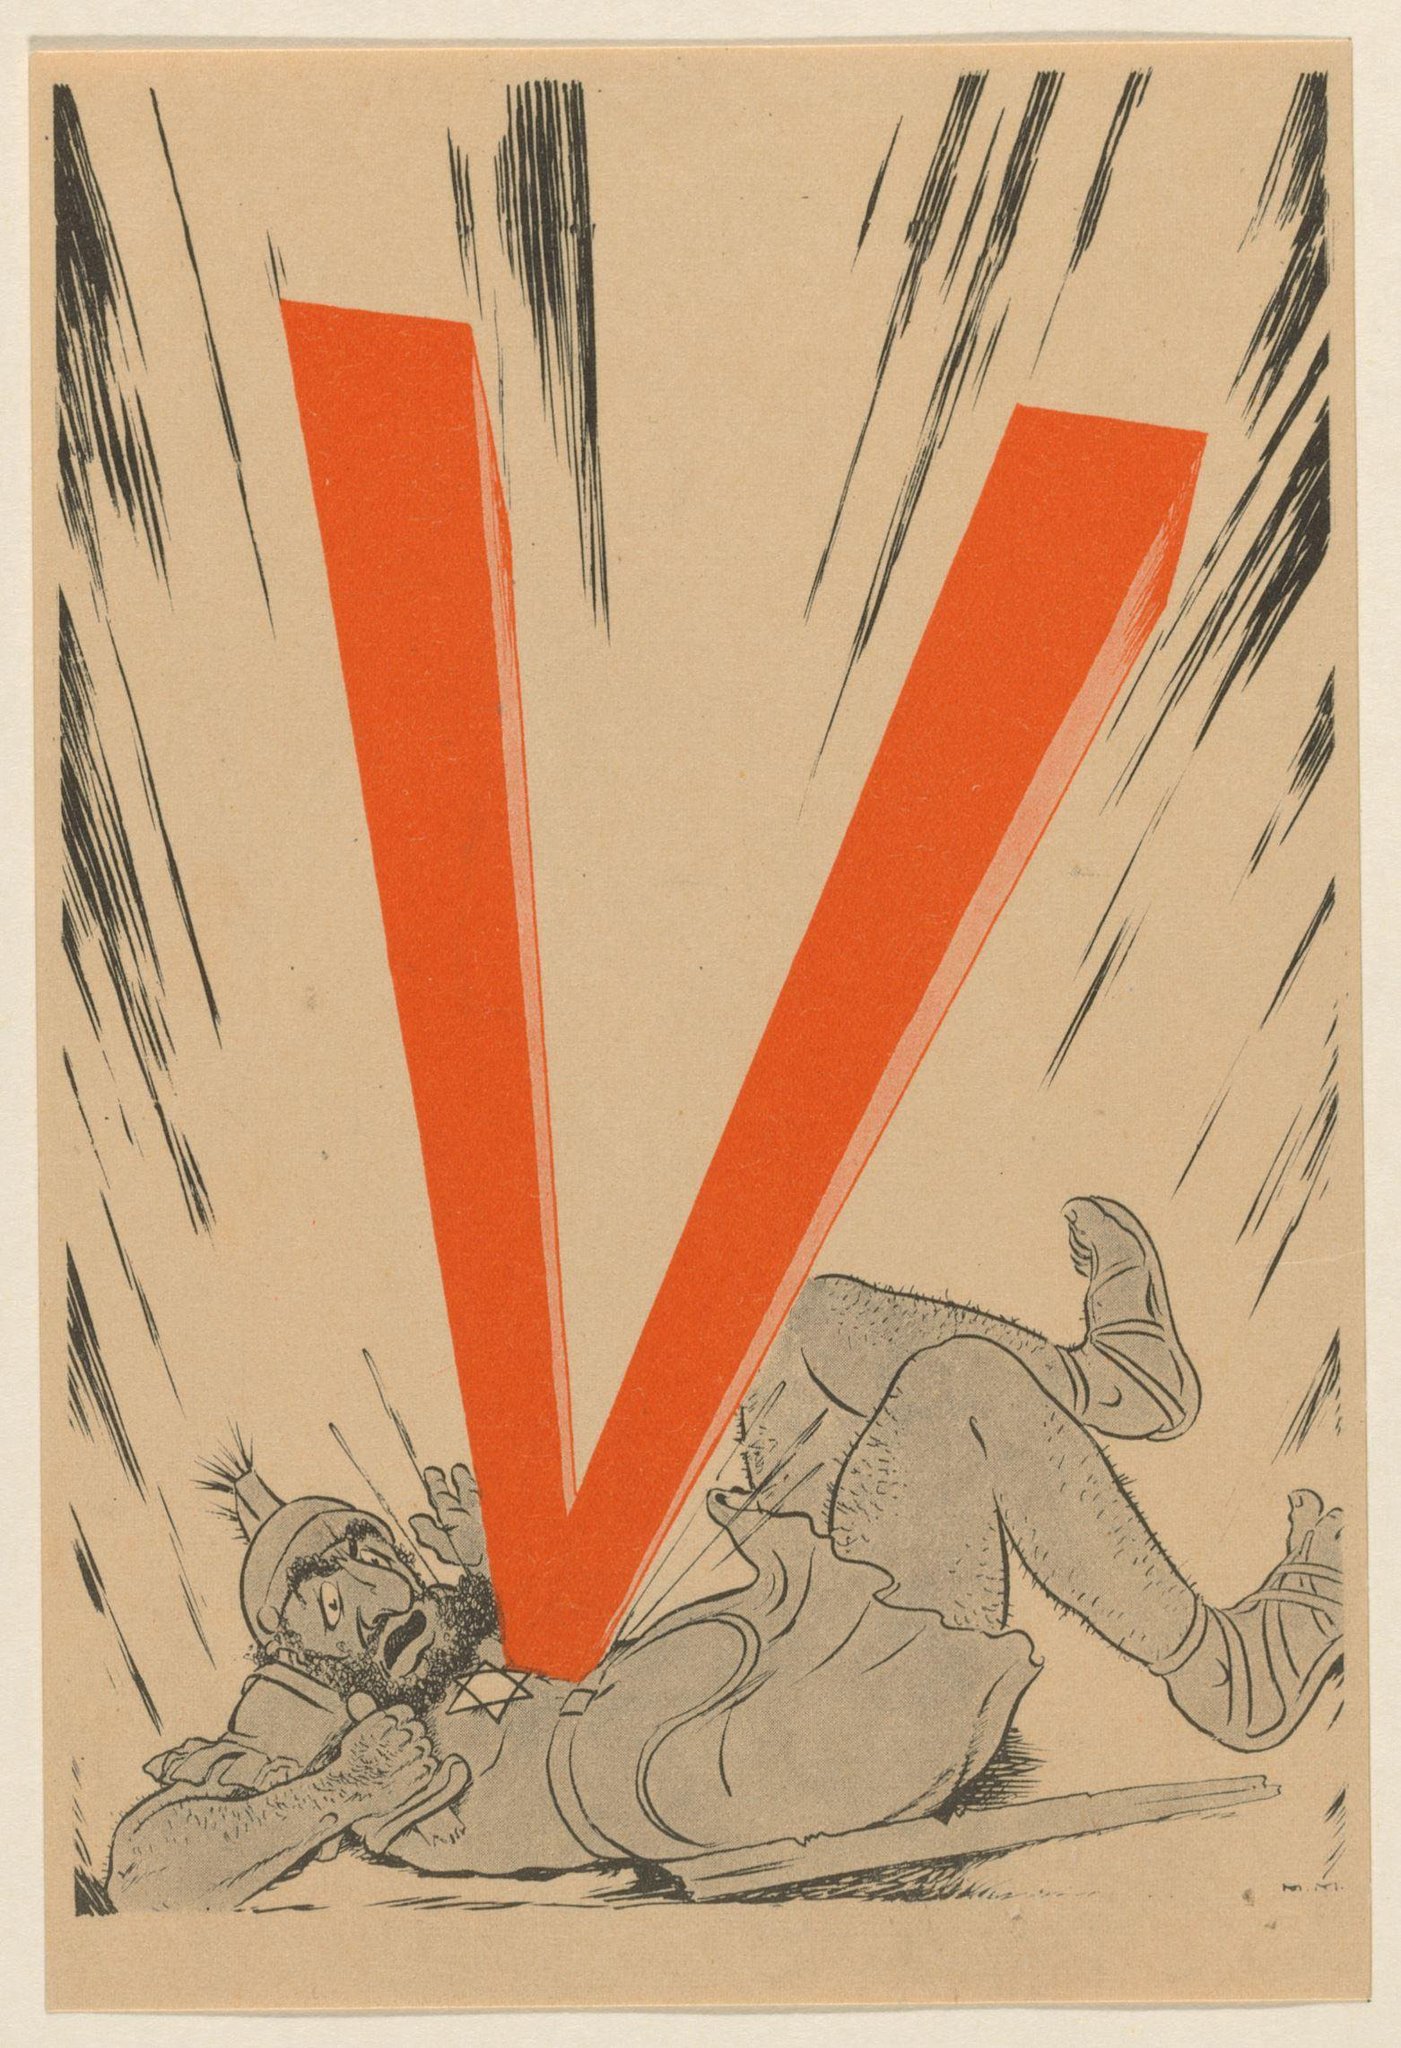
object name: cartoon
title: Anti-joodse spotprent, ca. 1943-1944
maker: Anonymous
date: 1943-1944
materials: paper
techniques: printed materials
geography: netherlands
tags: anti-semitism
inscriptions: collector's mark: Lugt 2228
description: Duitse anti-joodse spotprent, ca. 1943-1944. Een karikaturale joodse soldaat in antieke kleding, met davidster en gebroken zwaard, wordt getroffen door een grote 'V' (van Viktorie, Duitschland wint op alle fronten).